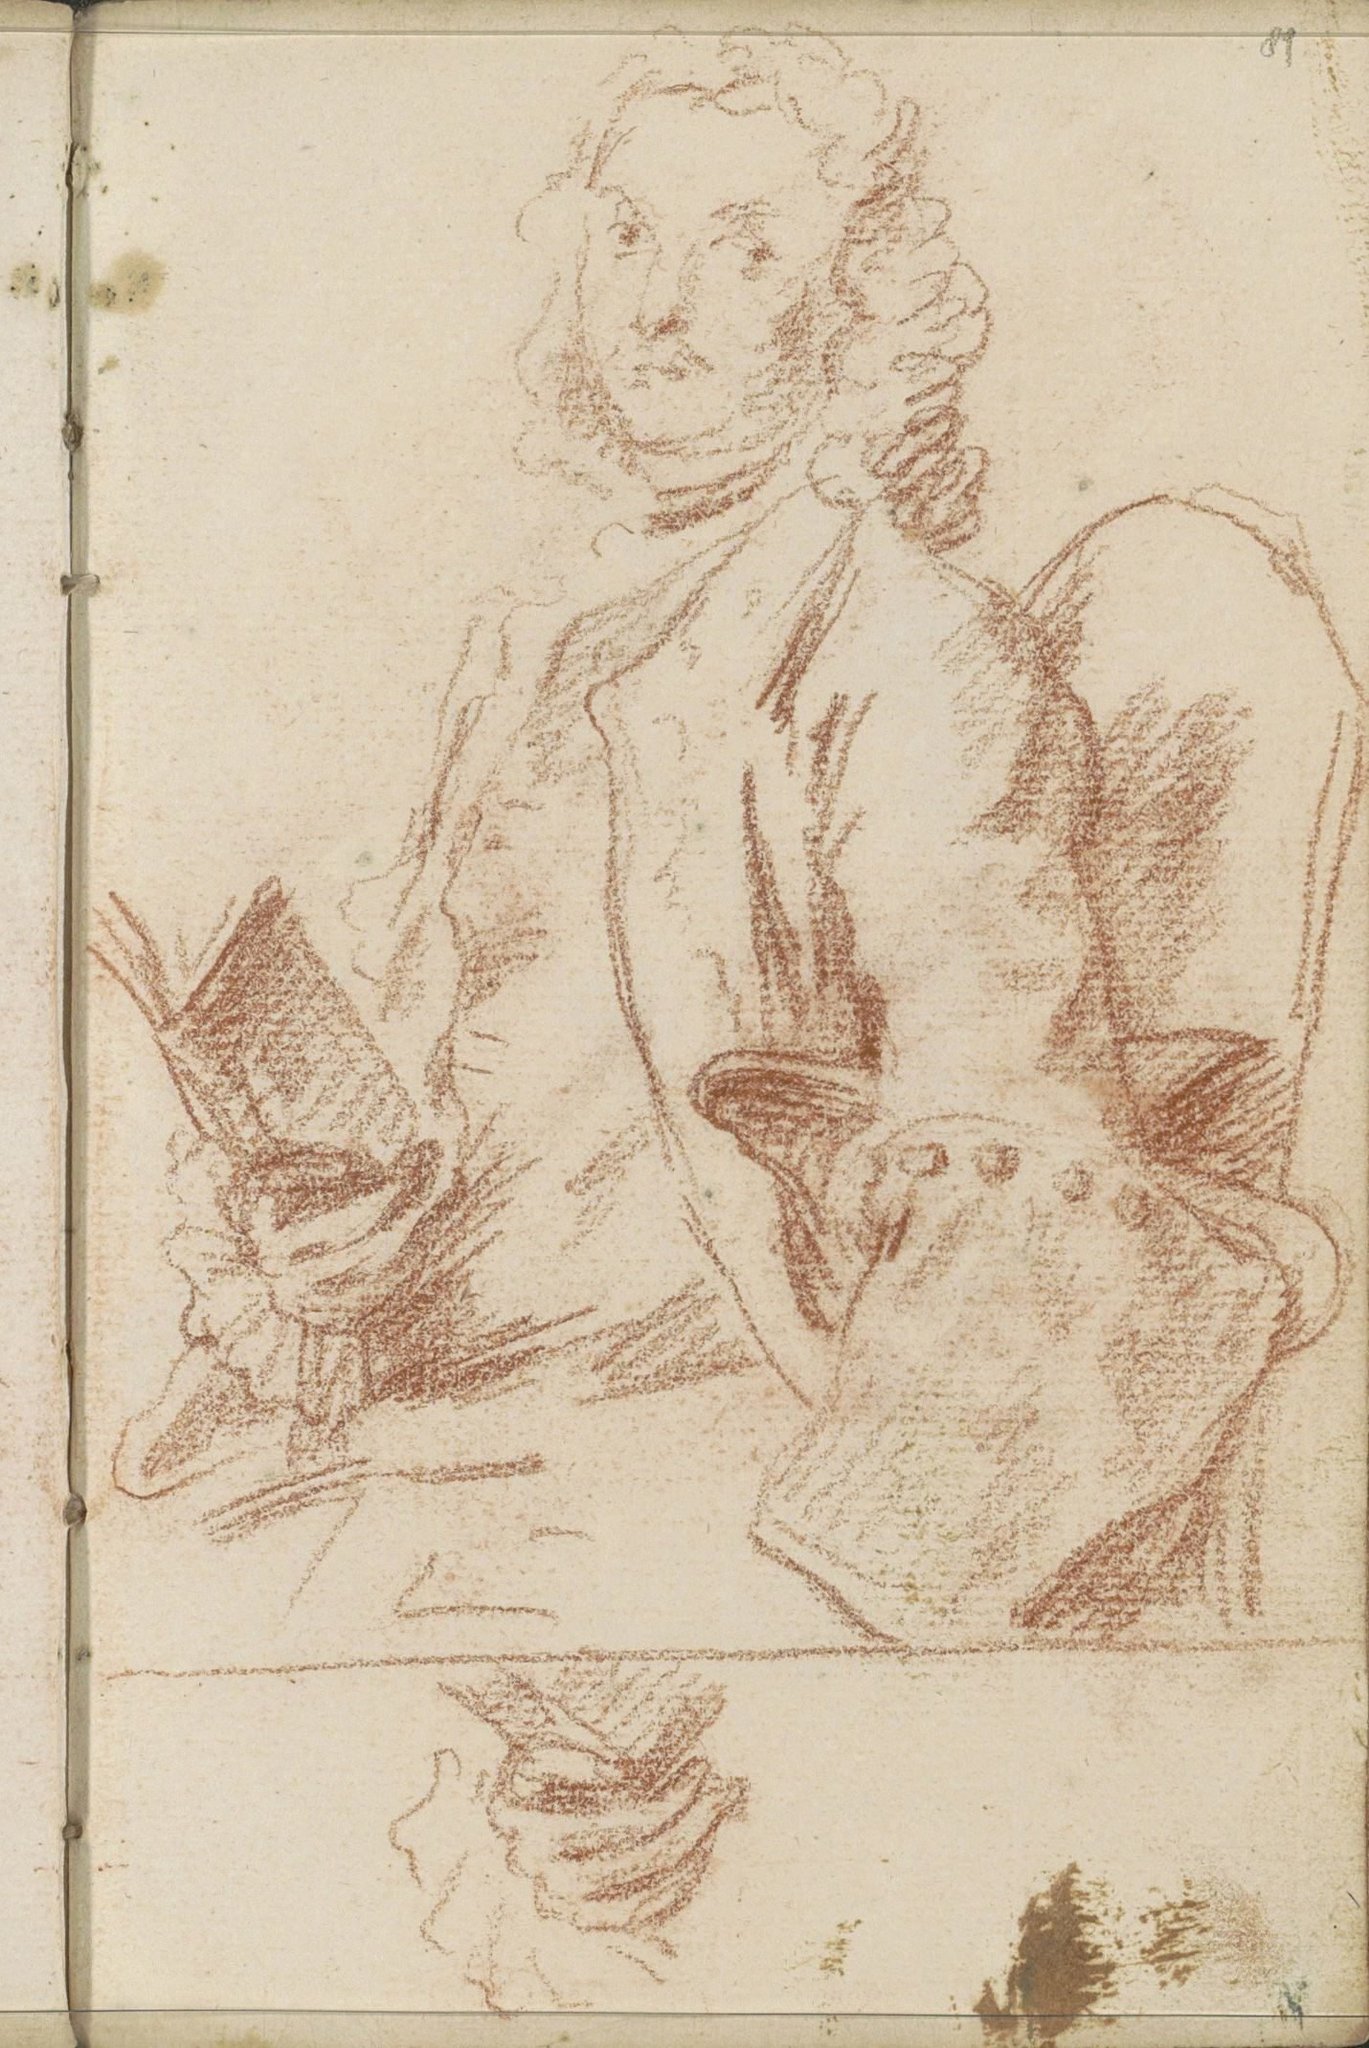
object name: sketchbook leaf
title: Zittende man met boek en een hand met een boek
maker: petrus johannes van reysschoot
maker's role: draughtsman, print maker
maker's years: 1702-1772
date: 1710-1772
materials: chalk, paper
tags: sitting figure, book - mm - book open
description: Blad 89 recto uit een schetsboek met 105 bladen.